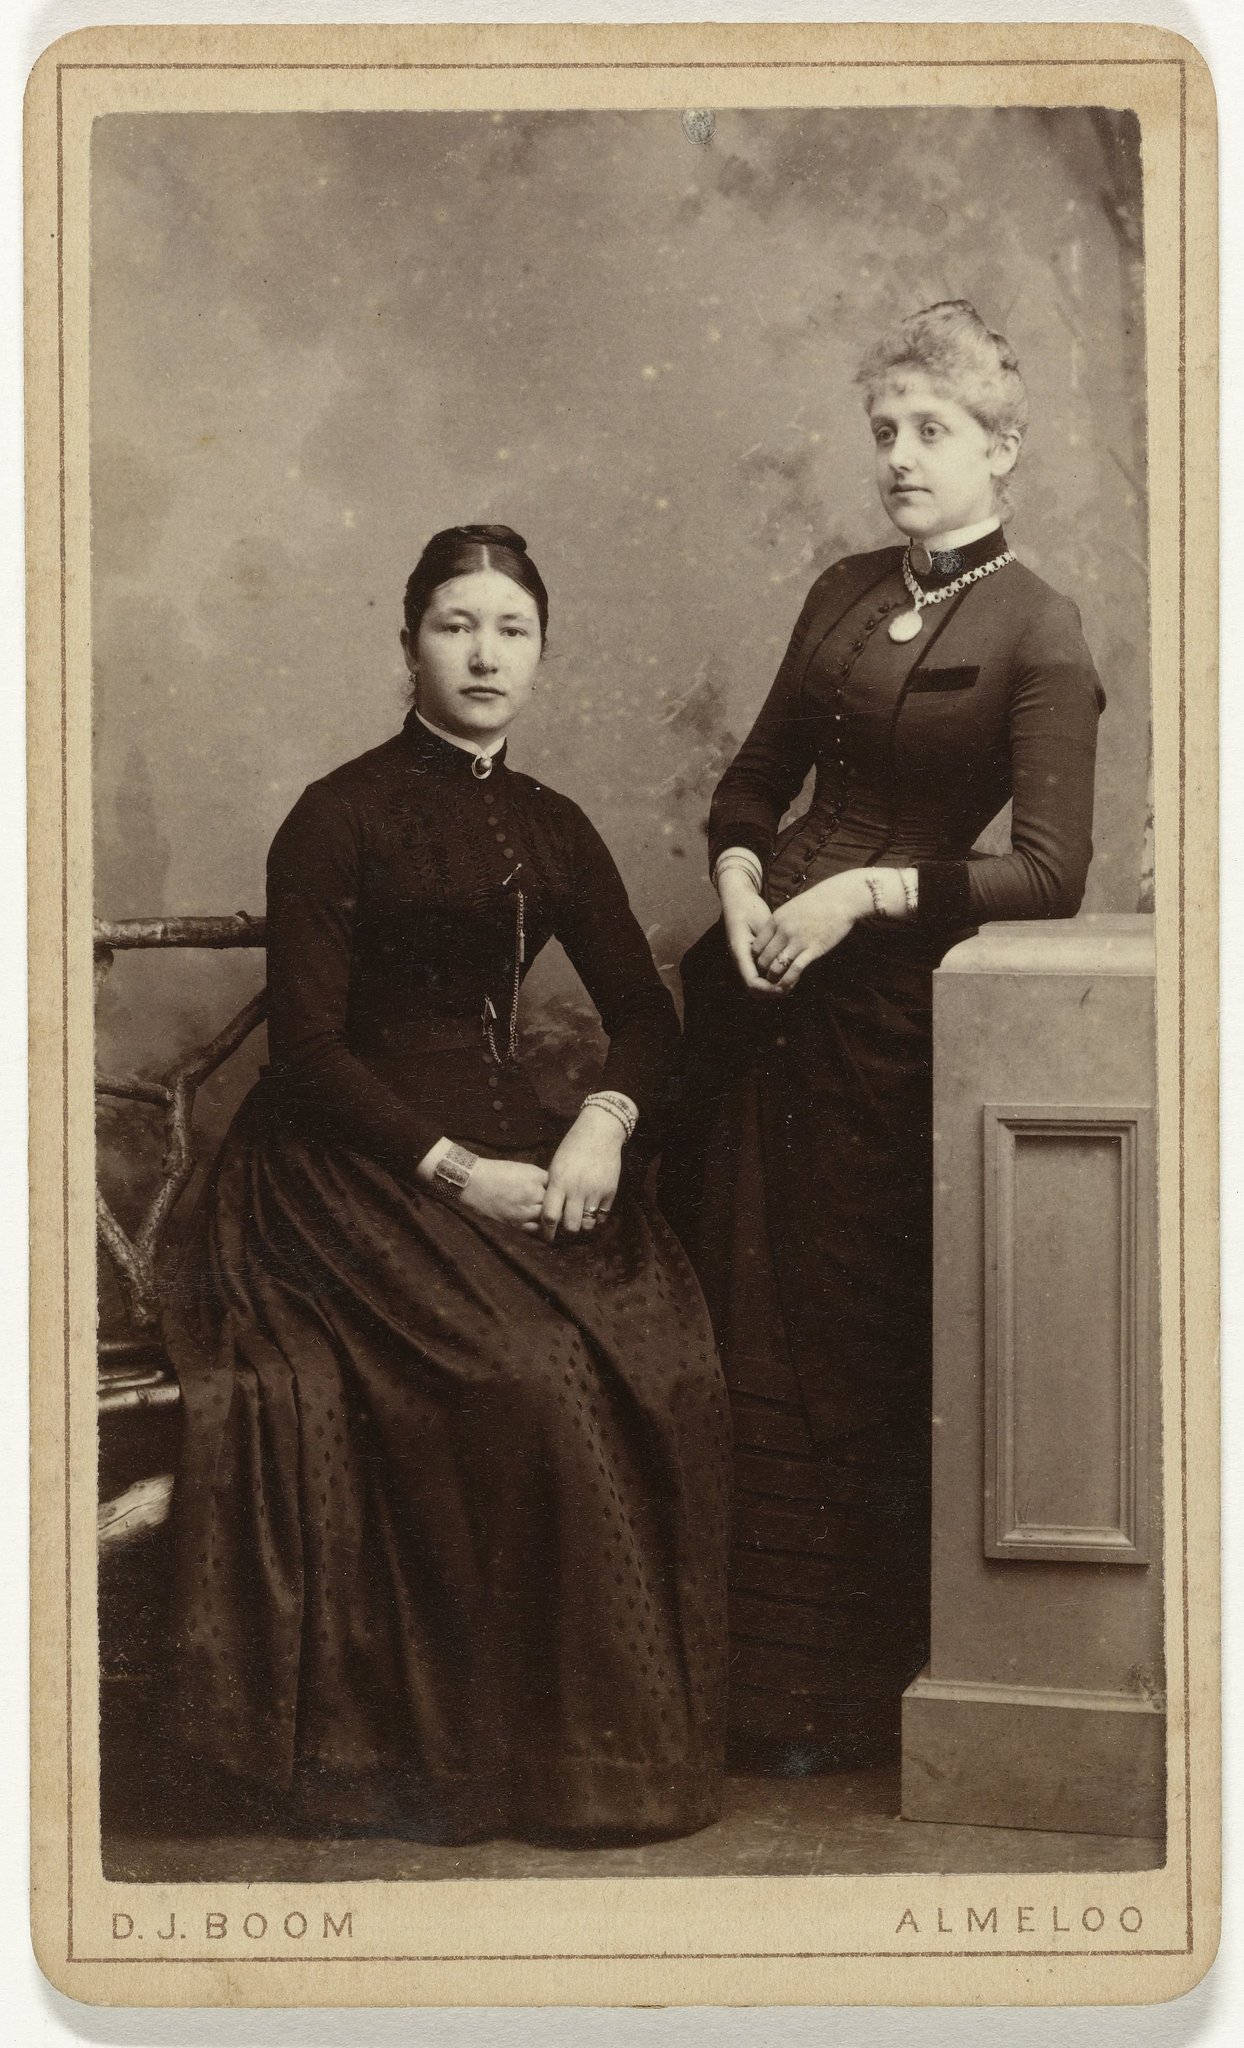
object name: carte de visite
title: Portret van twee vrouwen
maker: derk jan boom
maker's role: draughtsman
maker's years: 1853-1935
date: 1893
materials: cardboard, paper, photographic support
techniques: albumen print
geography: almelo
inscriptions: annotation: ‘Among today's wishes, true & tender,/From loving friends, to whom yr name is dear,/Take ours! And think with kindness of the sender/Glad be your birthday! joyous be your/New Year!/With kind love from Pauly’, annotation: ‘Van ieder portret kunnen artistieke/vergrootingen geleverd worden.’, address: ‘D.J. Boom/Photograaf/Portretteekenaar/Almeloo’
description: Twee jonge vrouwen, de een zittende op een tuinbank, de ander staand tegen een balustrade.